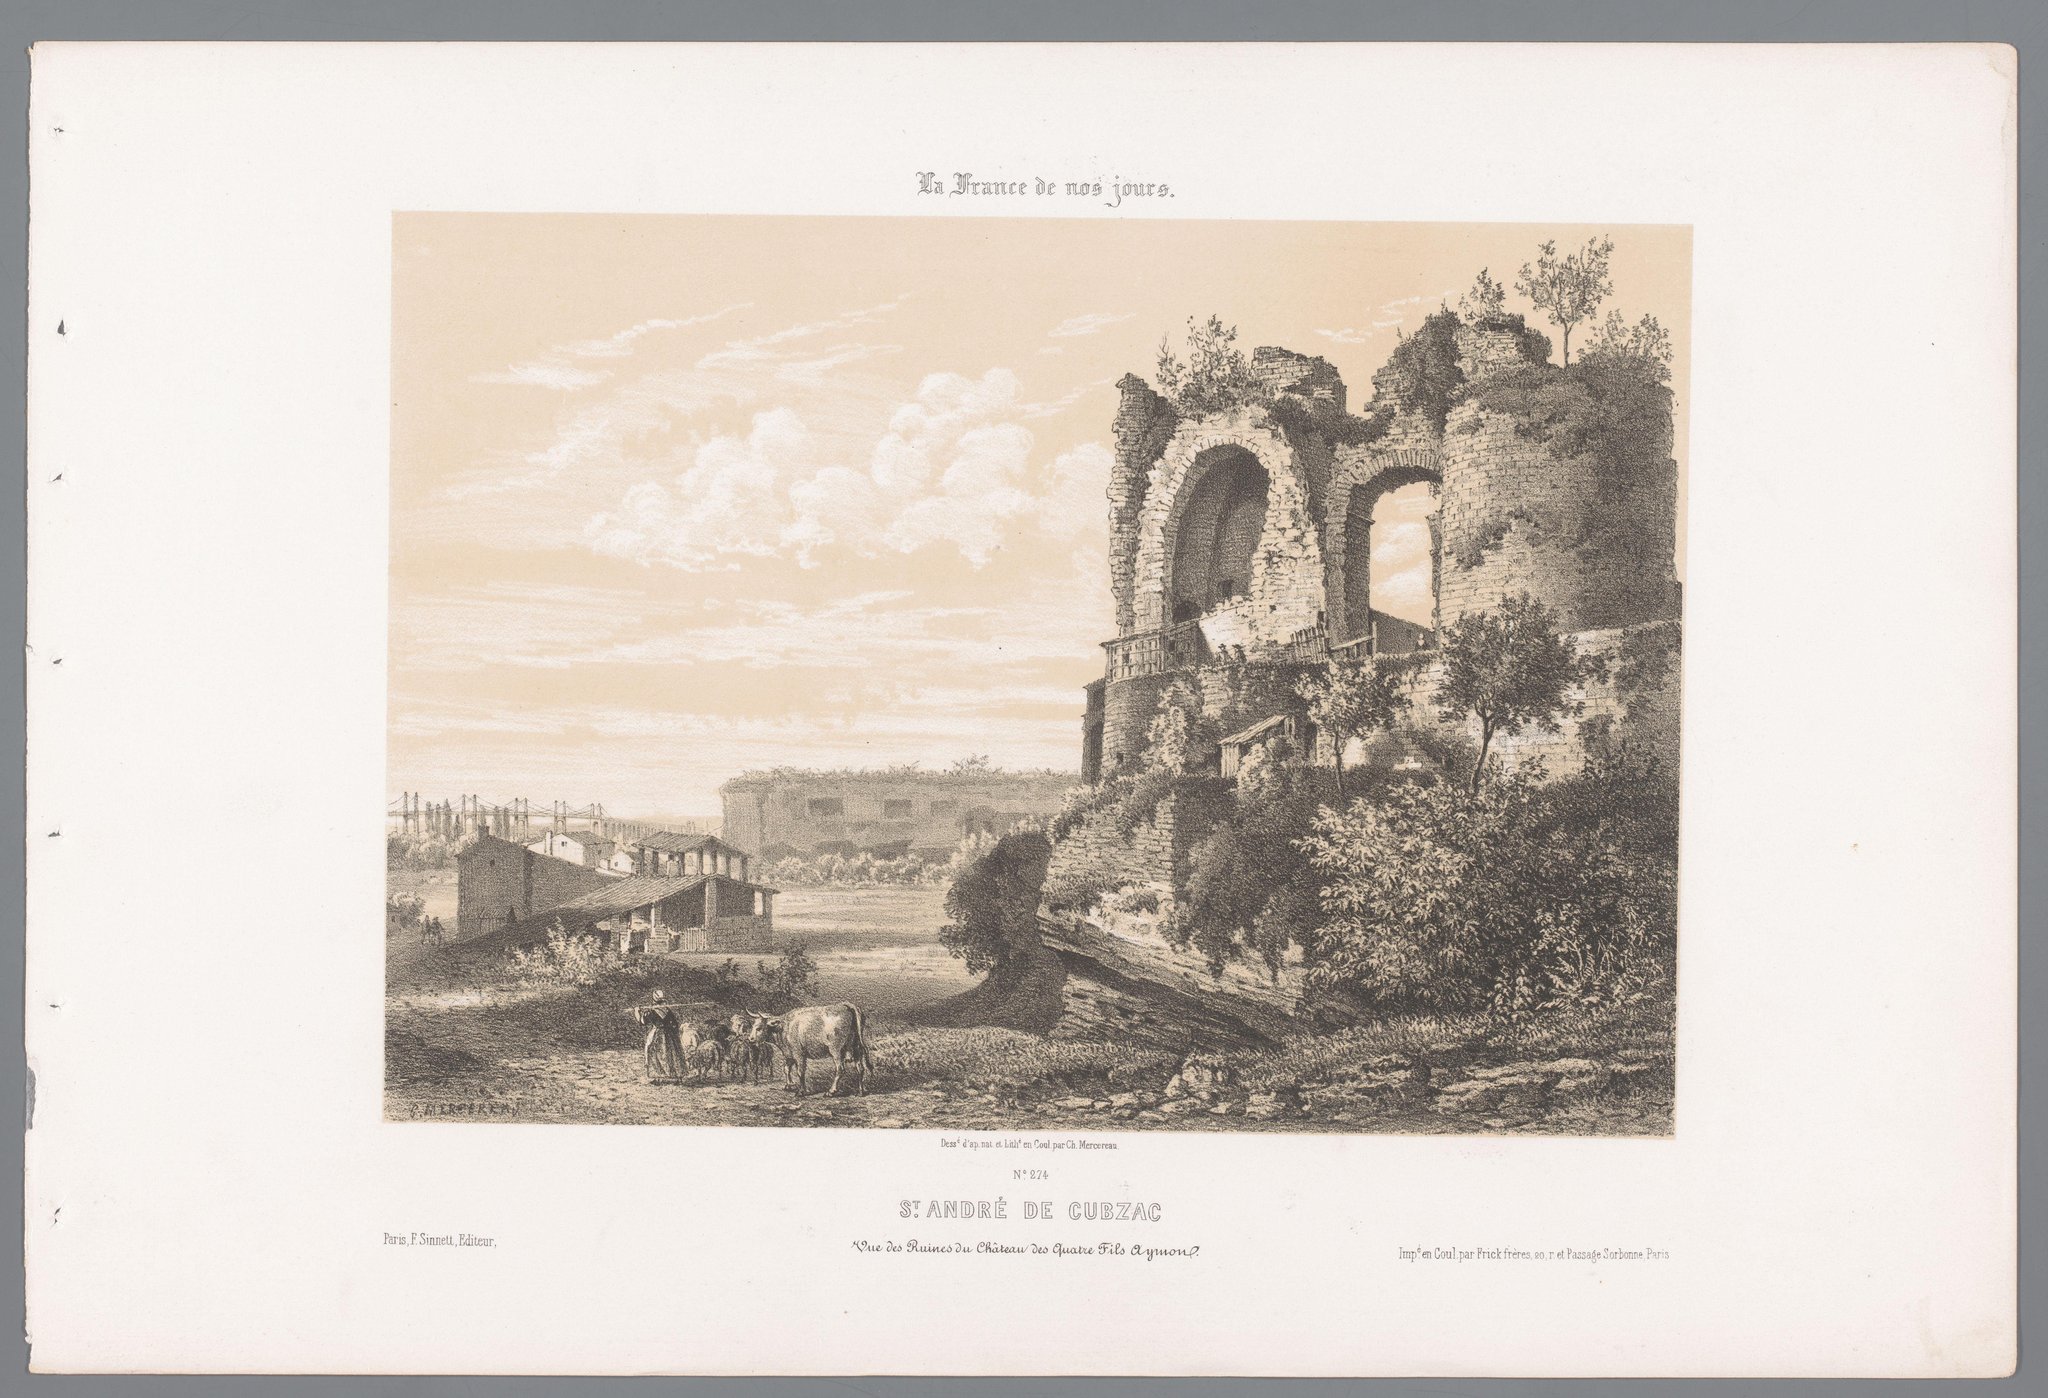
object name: print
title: Gezicht op de ruïnes van Château des Quatre Fils Aymon te Saint-André-de-Cubzac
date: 1856-1874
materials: paper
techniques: tone lithography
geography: paris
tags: city-view, and landscape with man-made constructions, bridge, ruin of a dwelling, house, castle, etc.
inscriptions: collector's mark: Lugt 2228